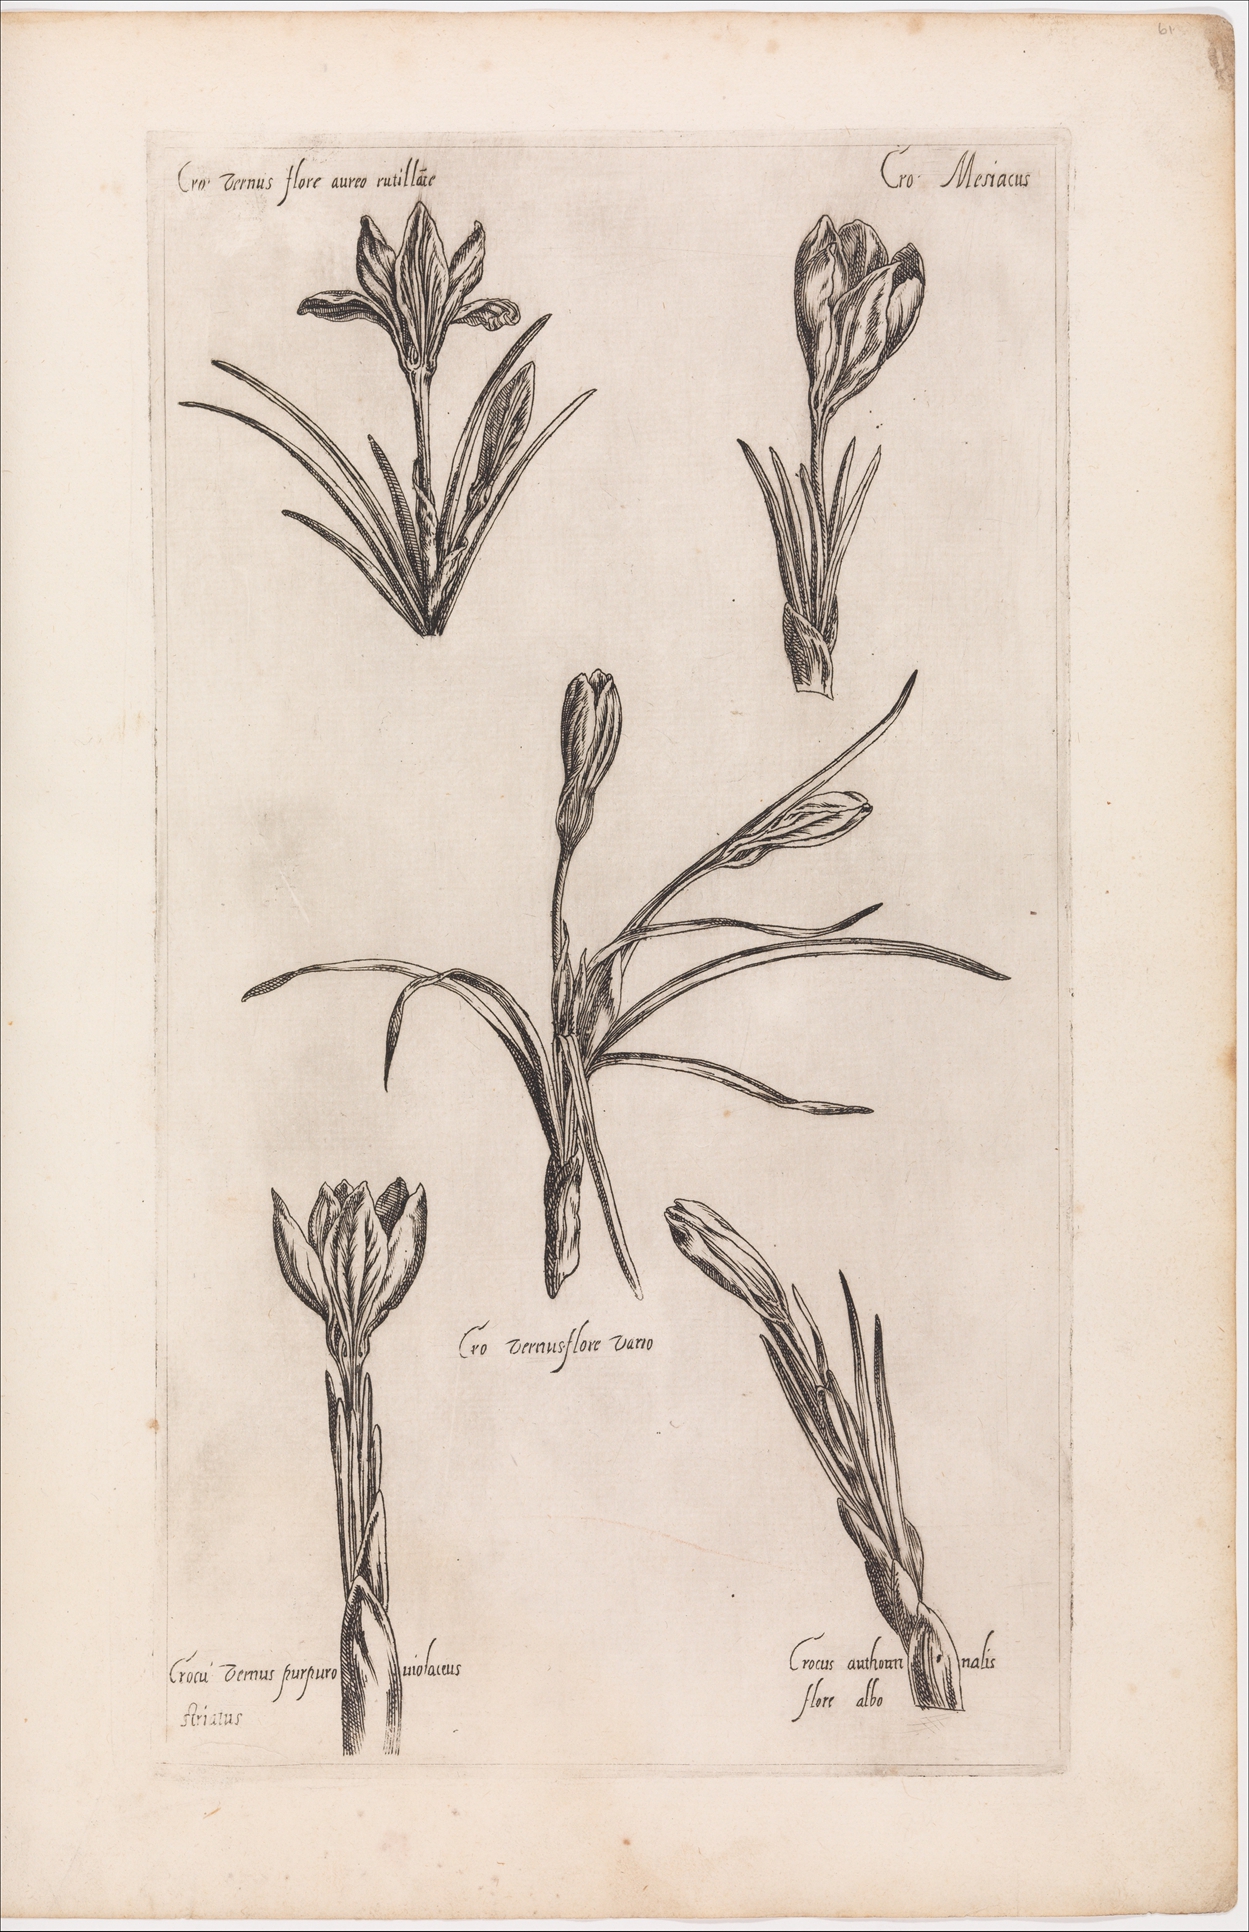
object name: book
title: Le Jardin du Roy tres Chrestien Henry IV roy de France et de Navare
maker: pierre vallet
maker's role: print maker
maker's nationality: french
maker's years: 1575-1657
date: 1608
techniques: etching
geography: france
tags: flowers,leaves